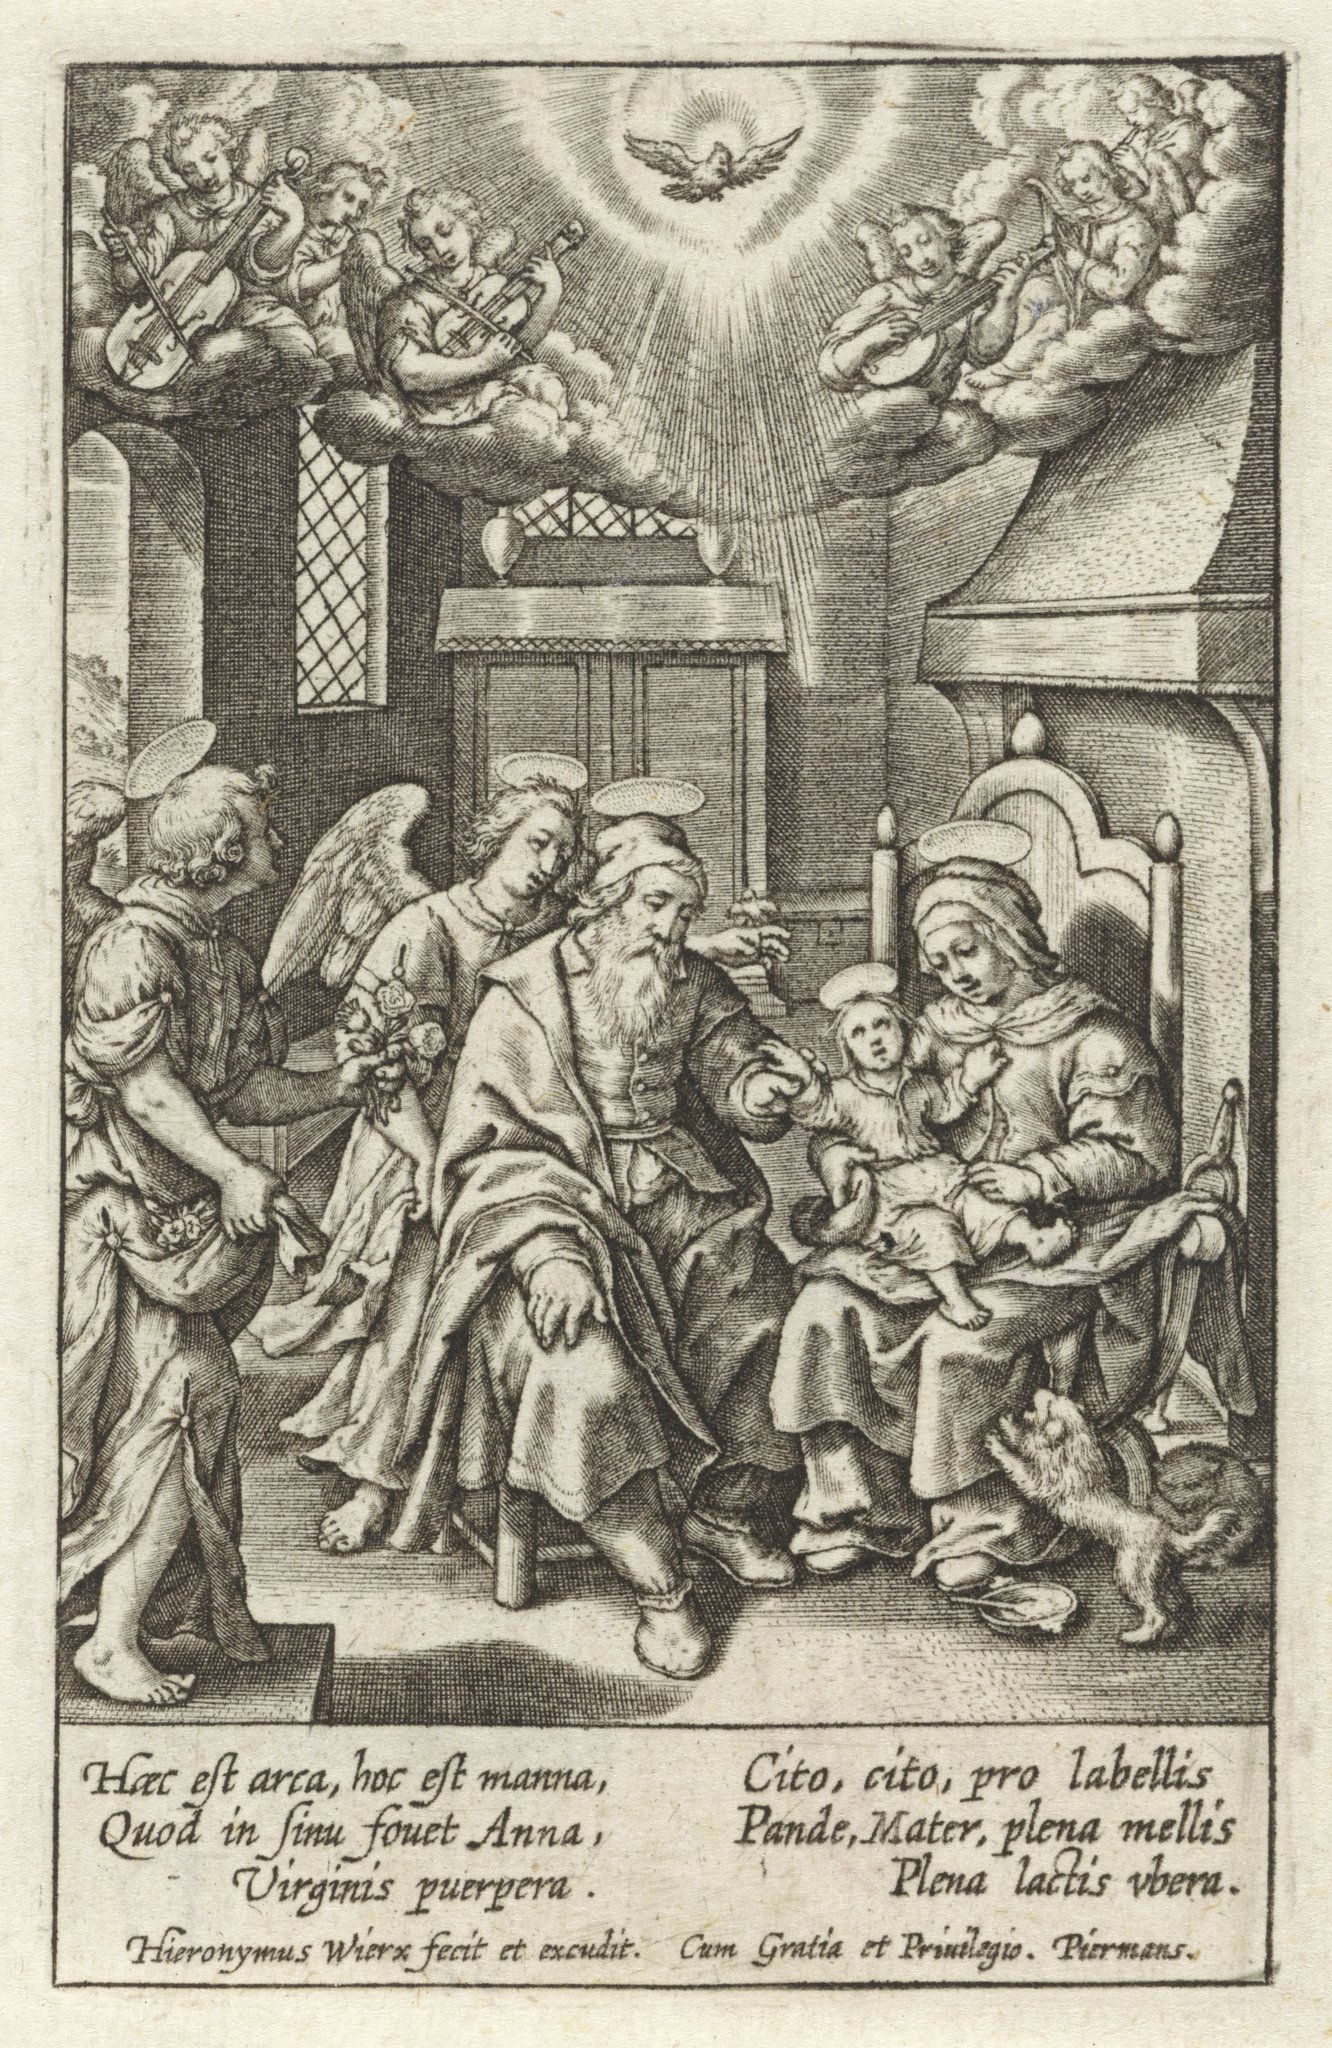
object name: print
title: Vita Deiparæ Virginis Mariæ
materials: paper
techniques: engraving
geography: antwerp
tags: (joachim and anna with) the baby mary (+ angel(s)), holy ghost represented as a dove (in flames)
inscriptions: collector's mark: Lugt 240, number: ‘46.’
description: De jonge Maria zit op de schoot van haar moeder Anna. Naast hen zit haar vader Joachim. Ze krijgen bezoek van twee engelen die hen bloemen brengen. In de lucht omgeven door hemelse stralen de Heilige Geest als duif, omringd door musicerende engelen. In de marge een zesregelig onderschrift, in twee kolommen, in het Latijn.